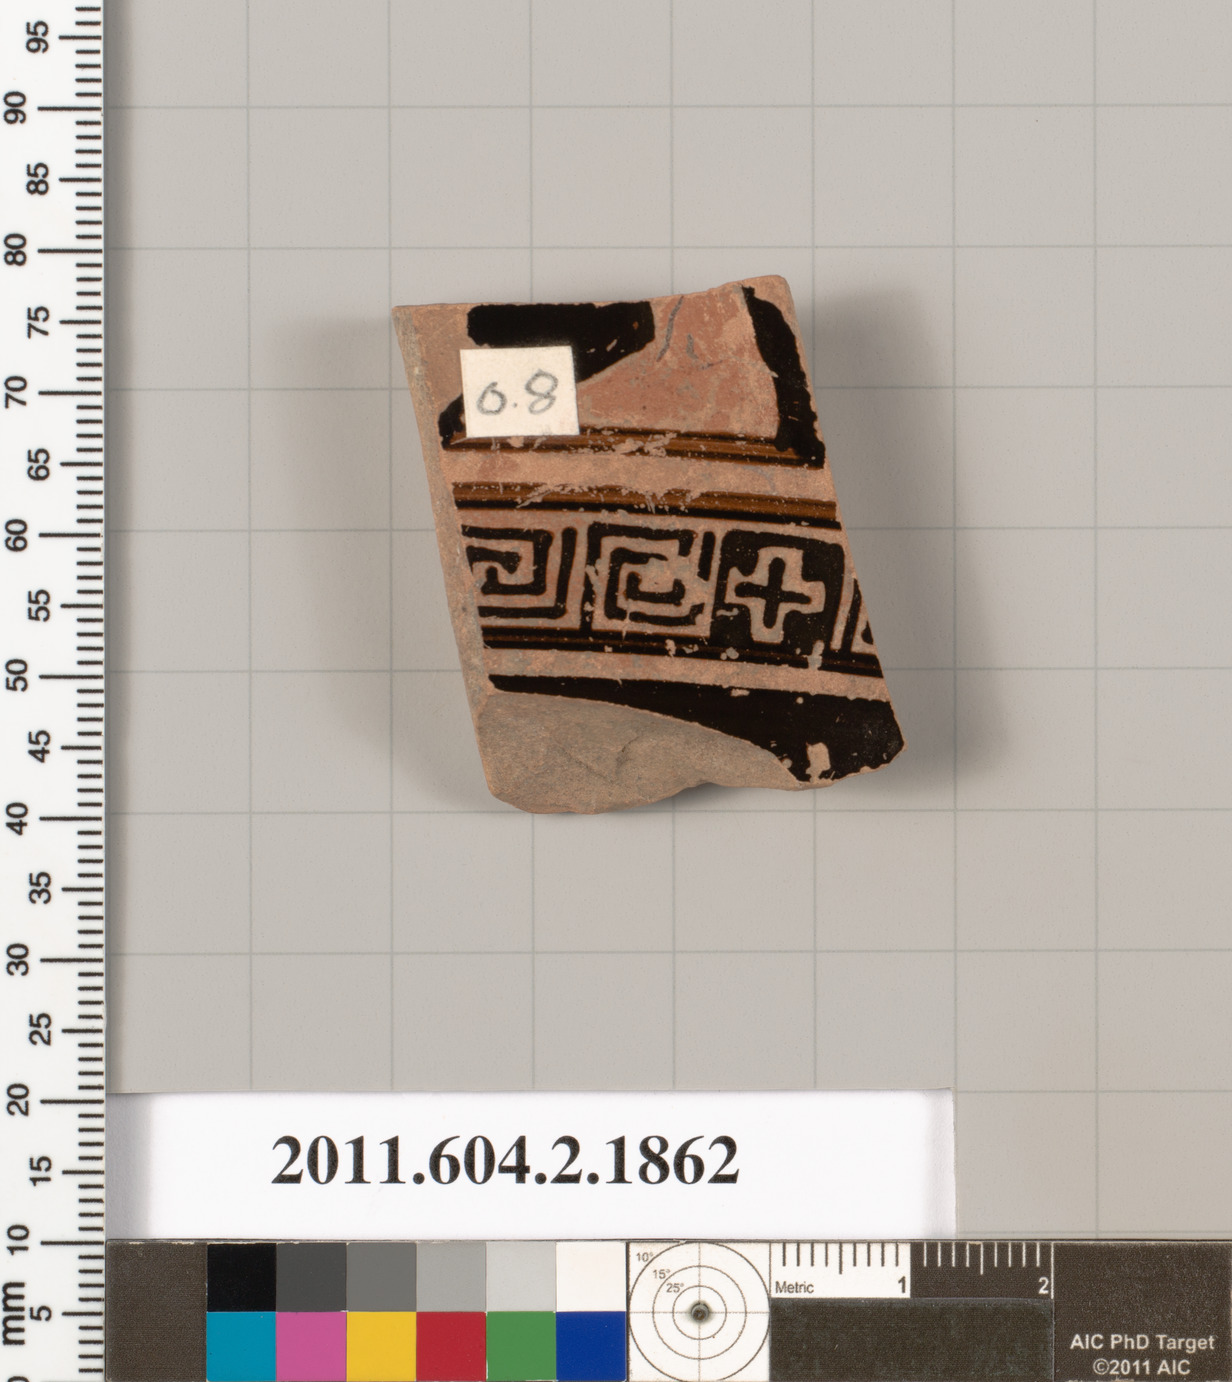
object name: skyphos fragment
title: Terracotta fragment of a skyphos (deep drinking cup)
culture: greek, attic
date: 460-450 BCE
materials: terracotta